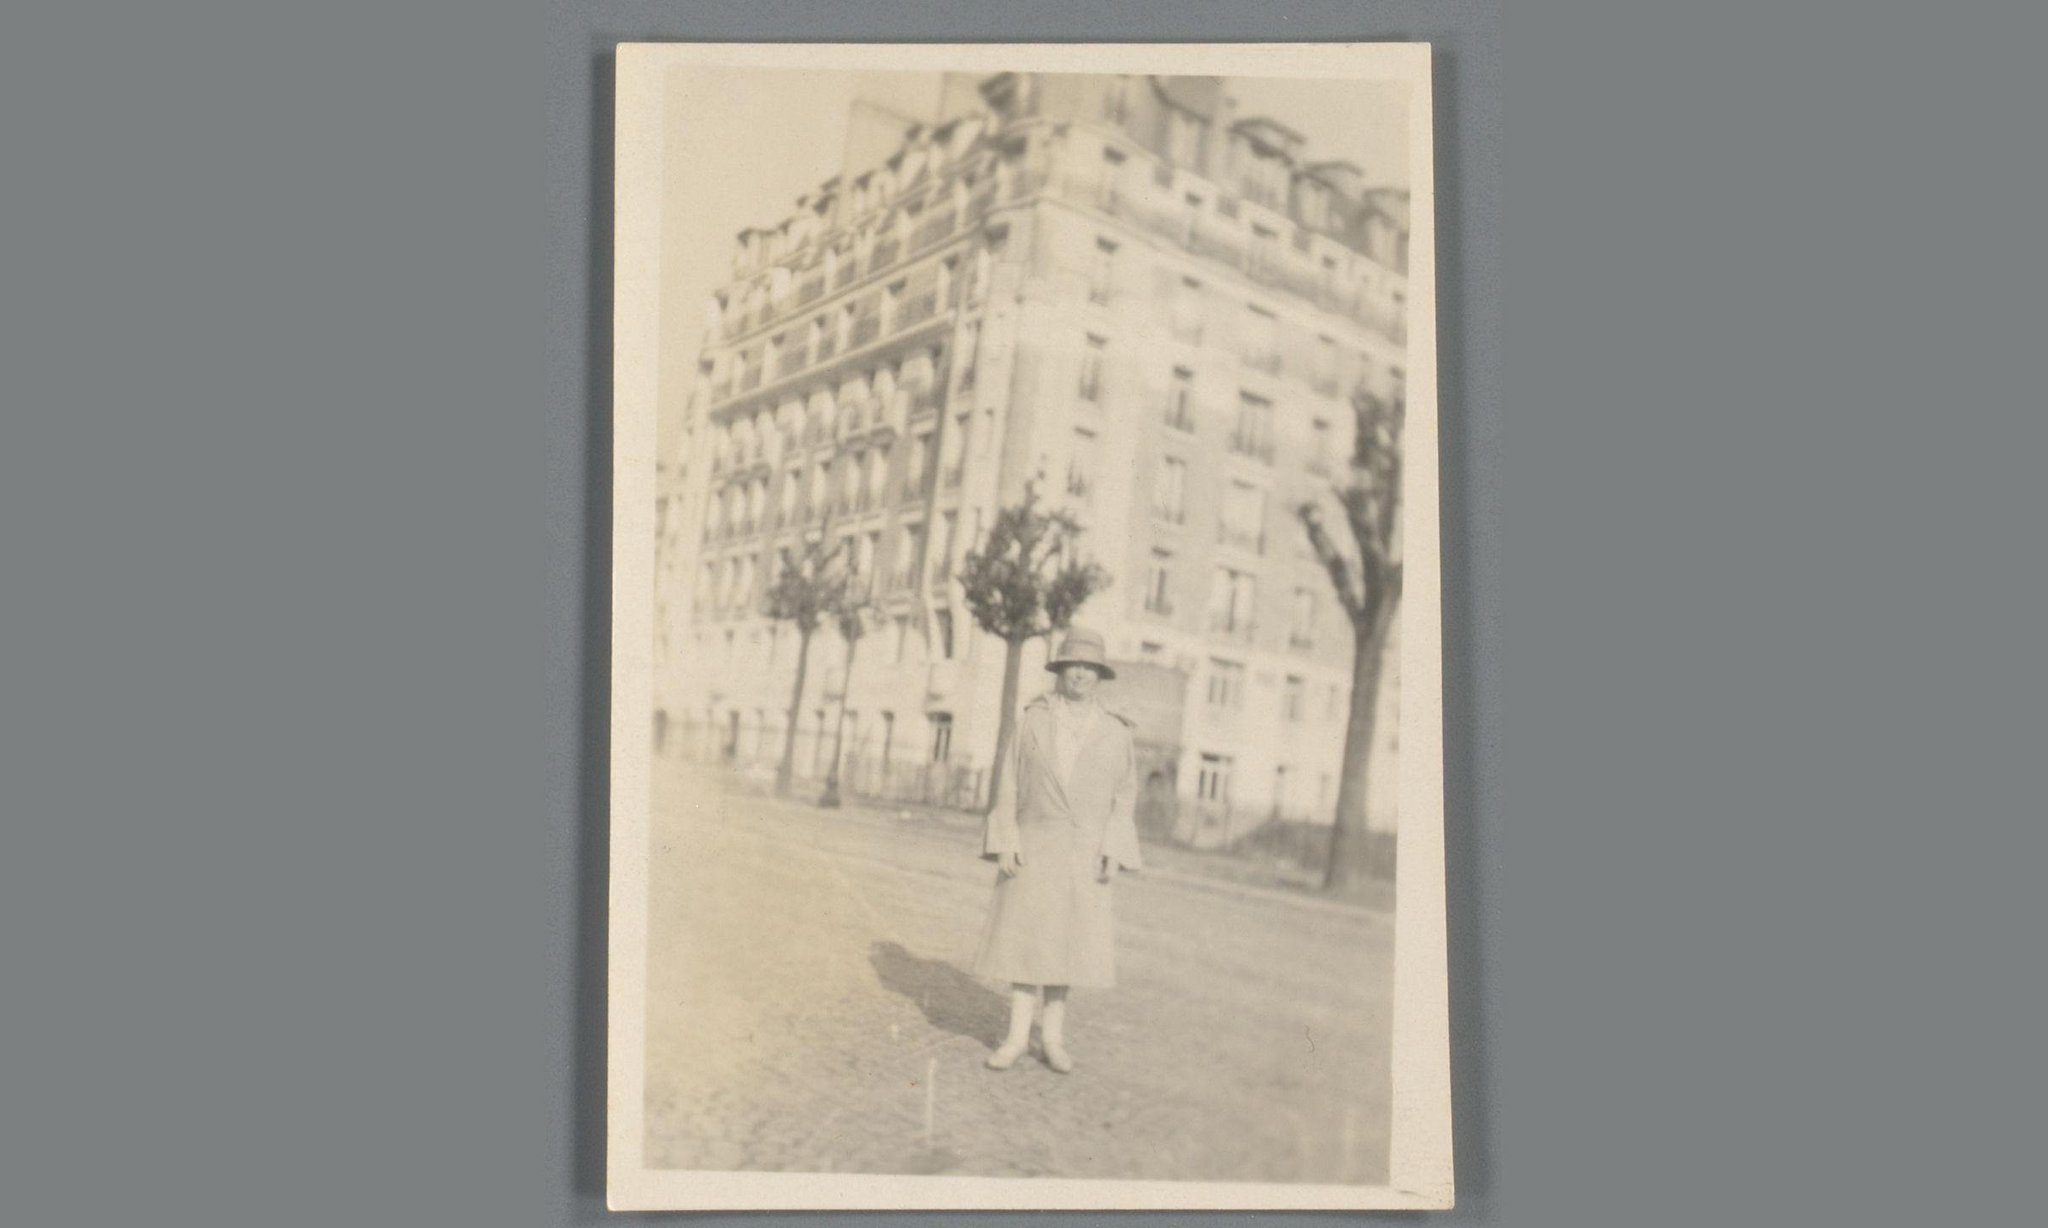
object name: photograph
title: Vrouw op straat, voor een gebouw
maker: Anonymous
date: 1900-1920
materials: paper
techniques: gelatin silver print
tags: adult woman